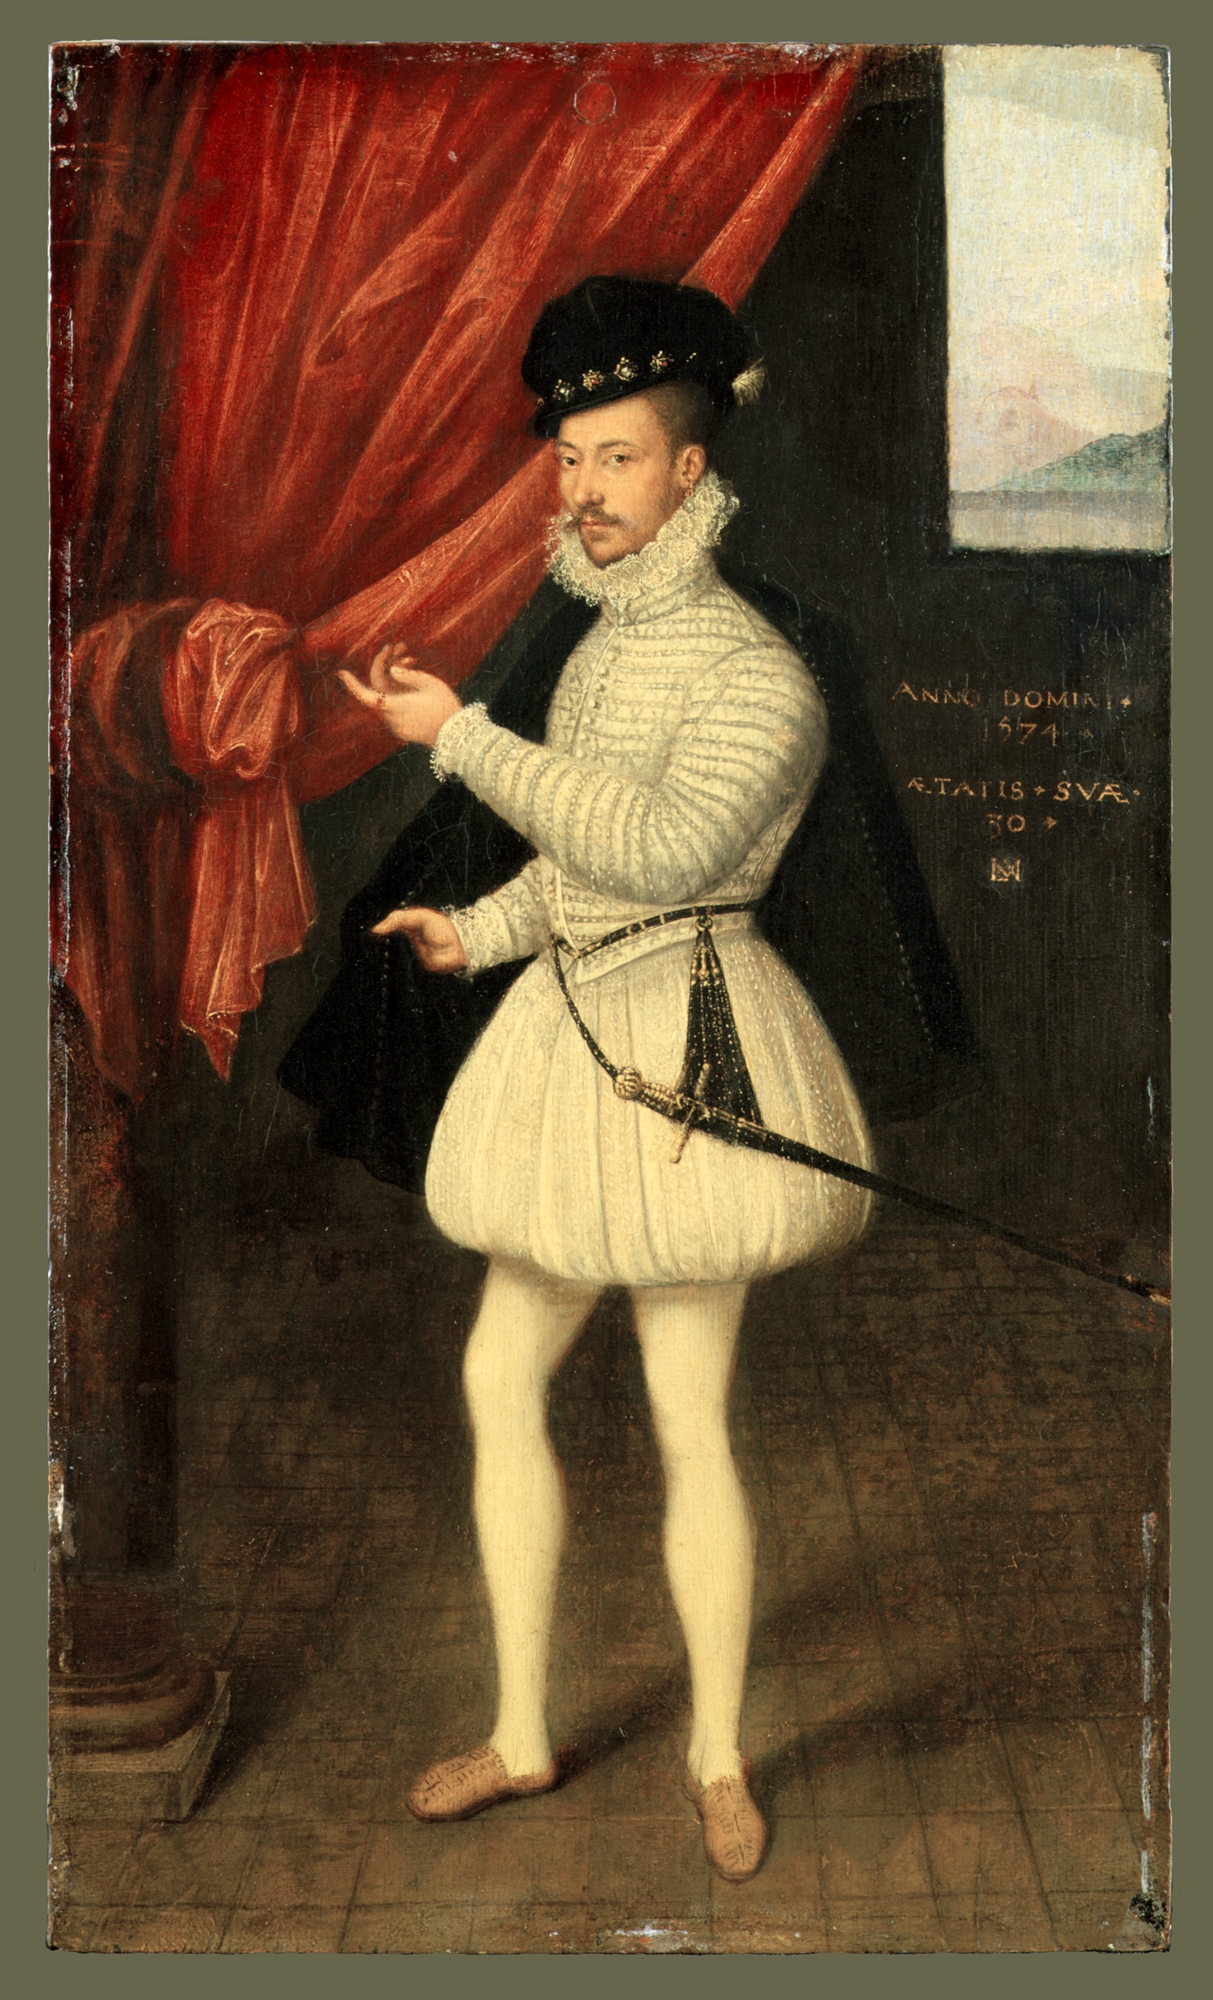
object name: painting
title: Portrait of a Man in White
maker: monogrammist lam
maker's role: artist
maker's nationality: french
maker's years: 1568-1574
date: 1574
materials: oil, wood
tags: men,portraits